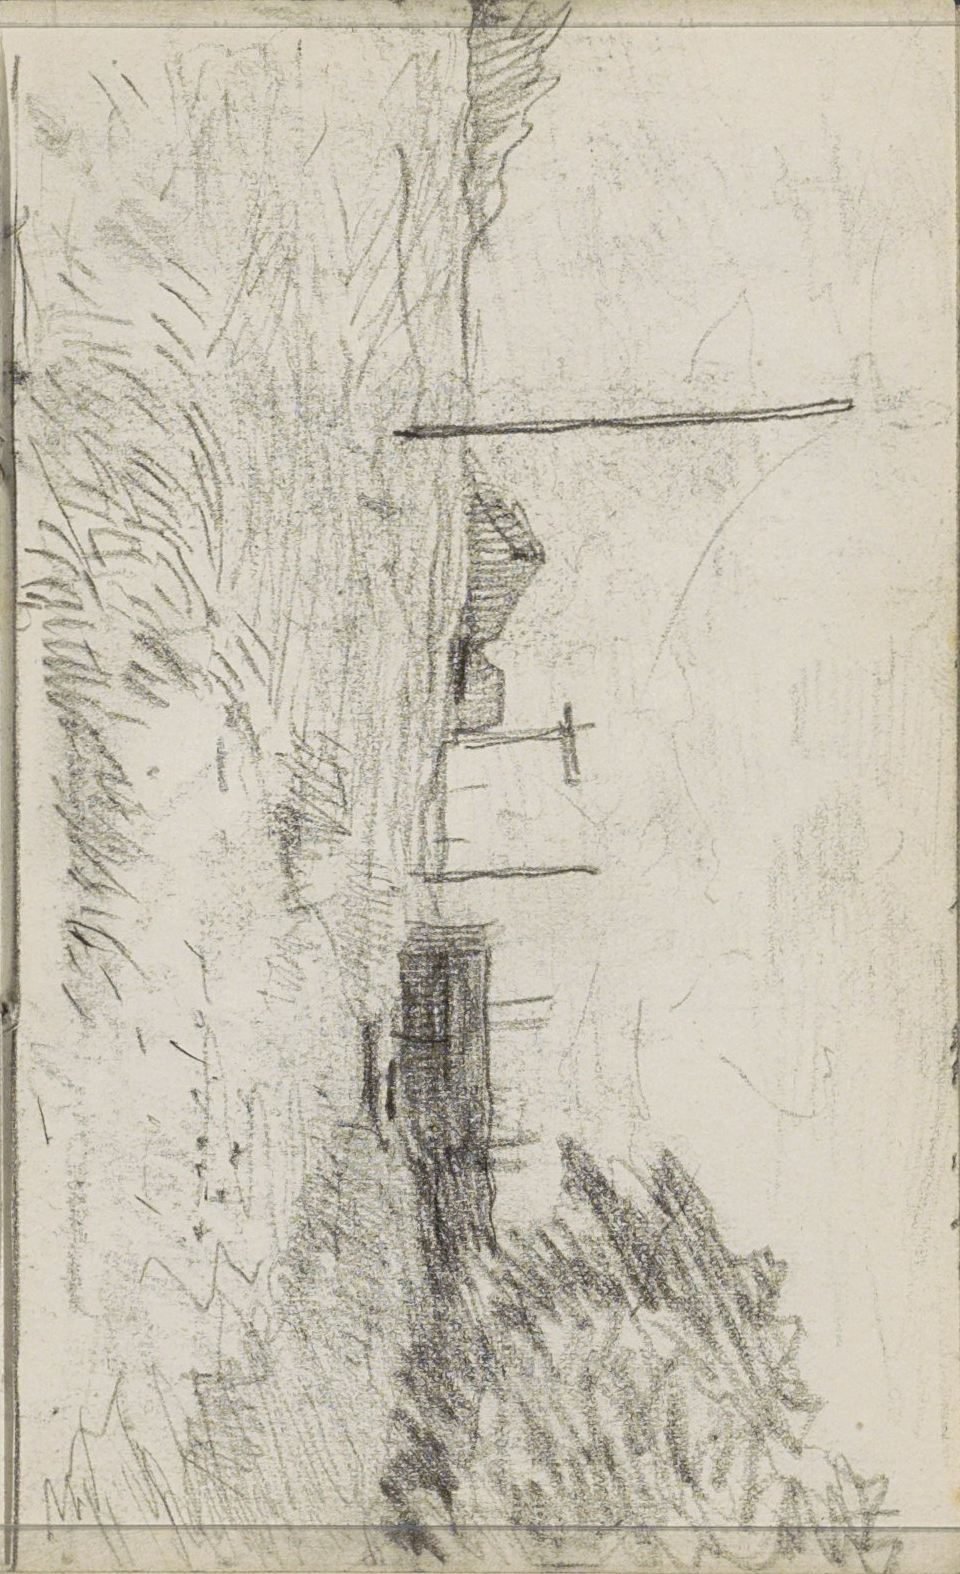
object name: sketchbook leaf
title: Huis, mogelijk een boerderij, op het platteland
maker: anton mauve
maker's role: draughtsman, painter, print maker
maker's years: 1838-1888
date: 1848-1888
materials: chalk, paper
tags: farm or solitary house in landscape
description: In het landschap staan houten palen waartussen een touw is gespannen. Blad 30 recto uit een schetsboek met 53 bladen.